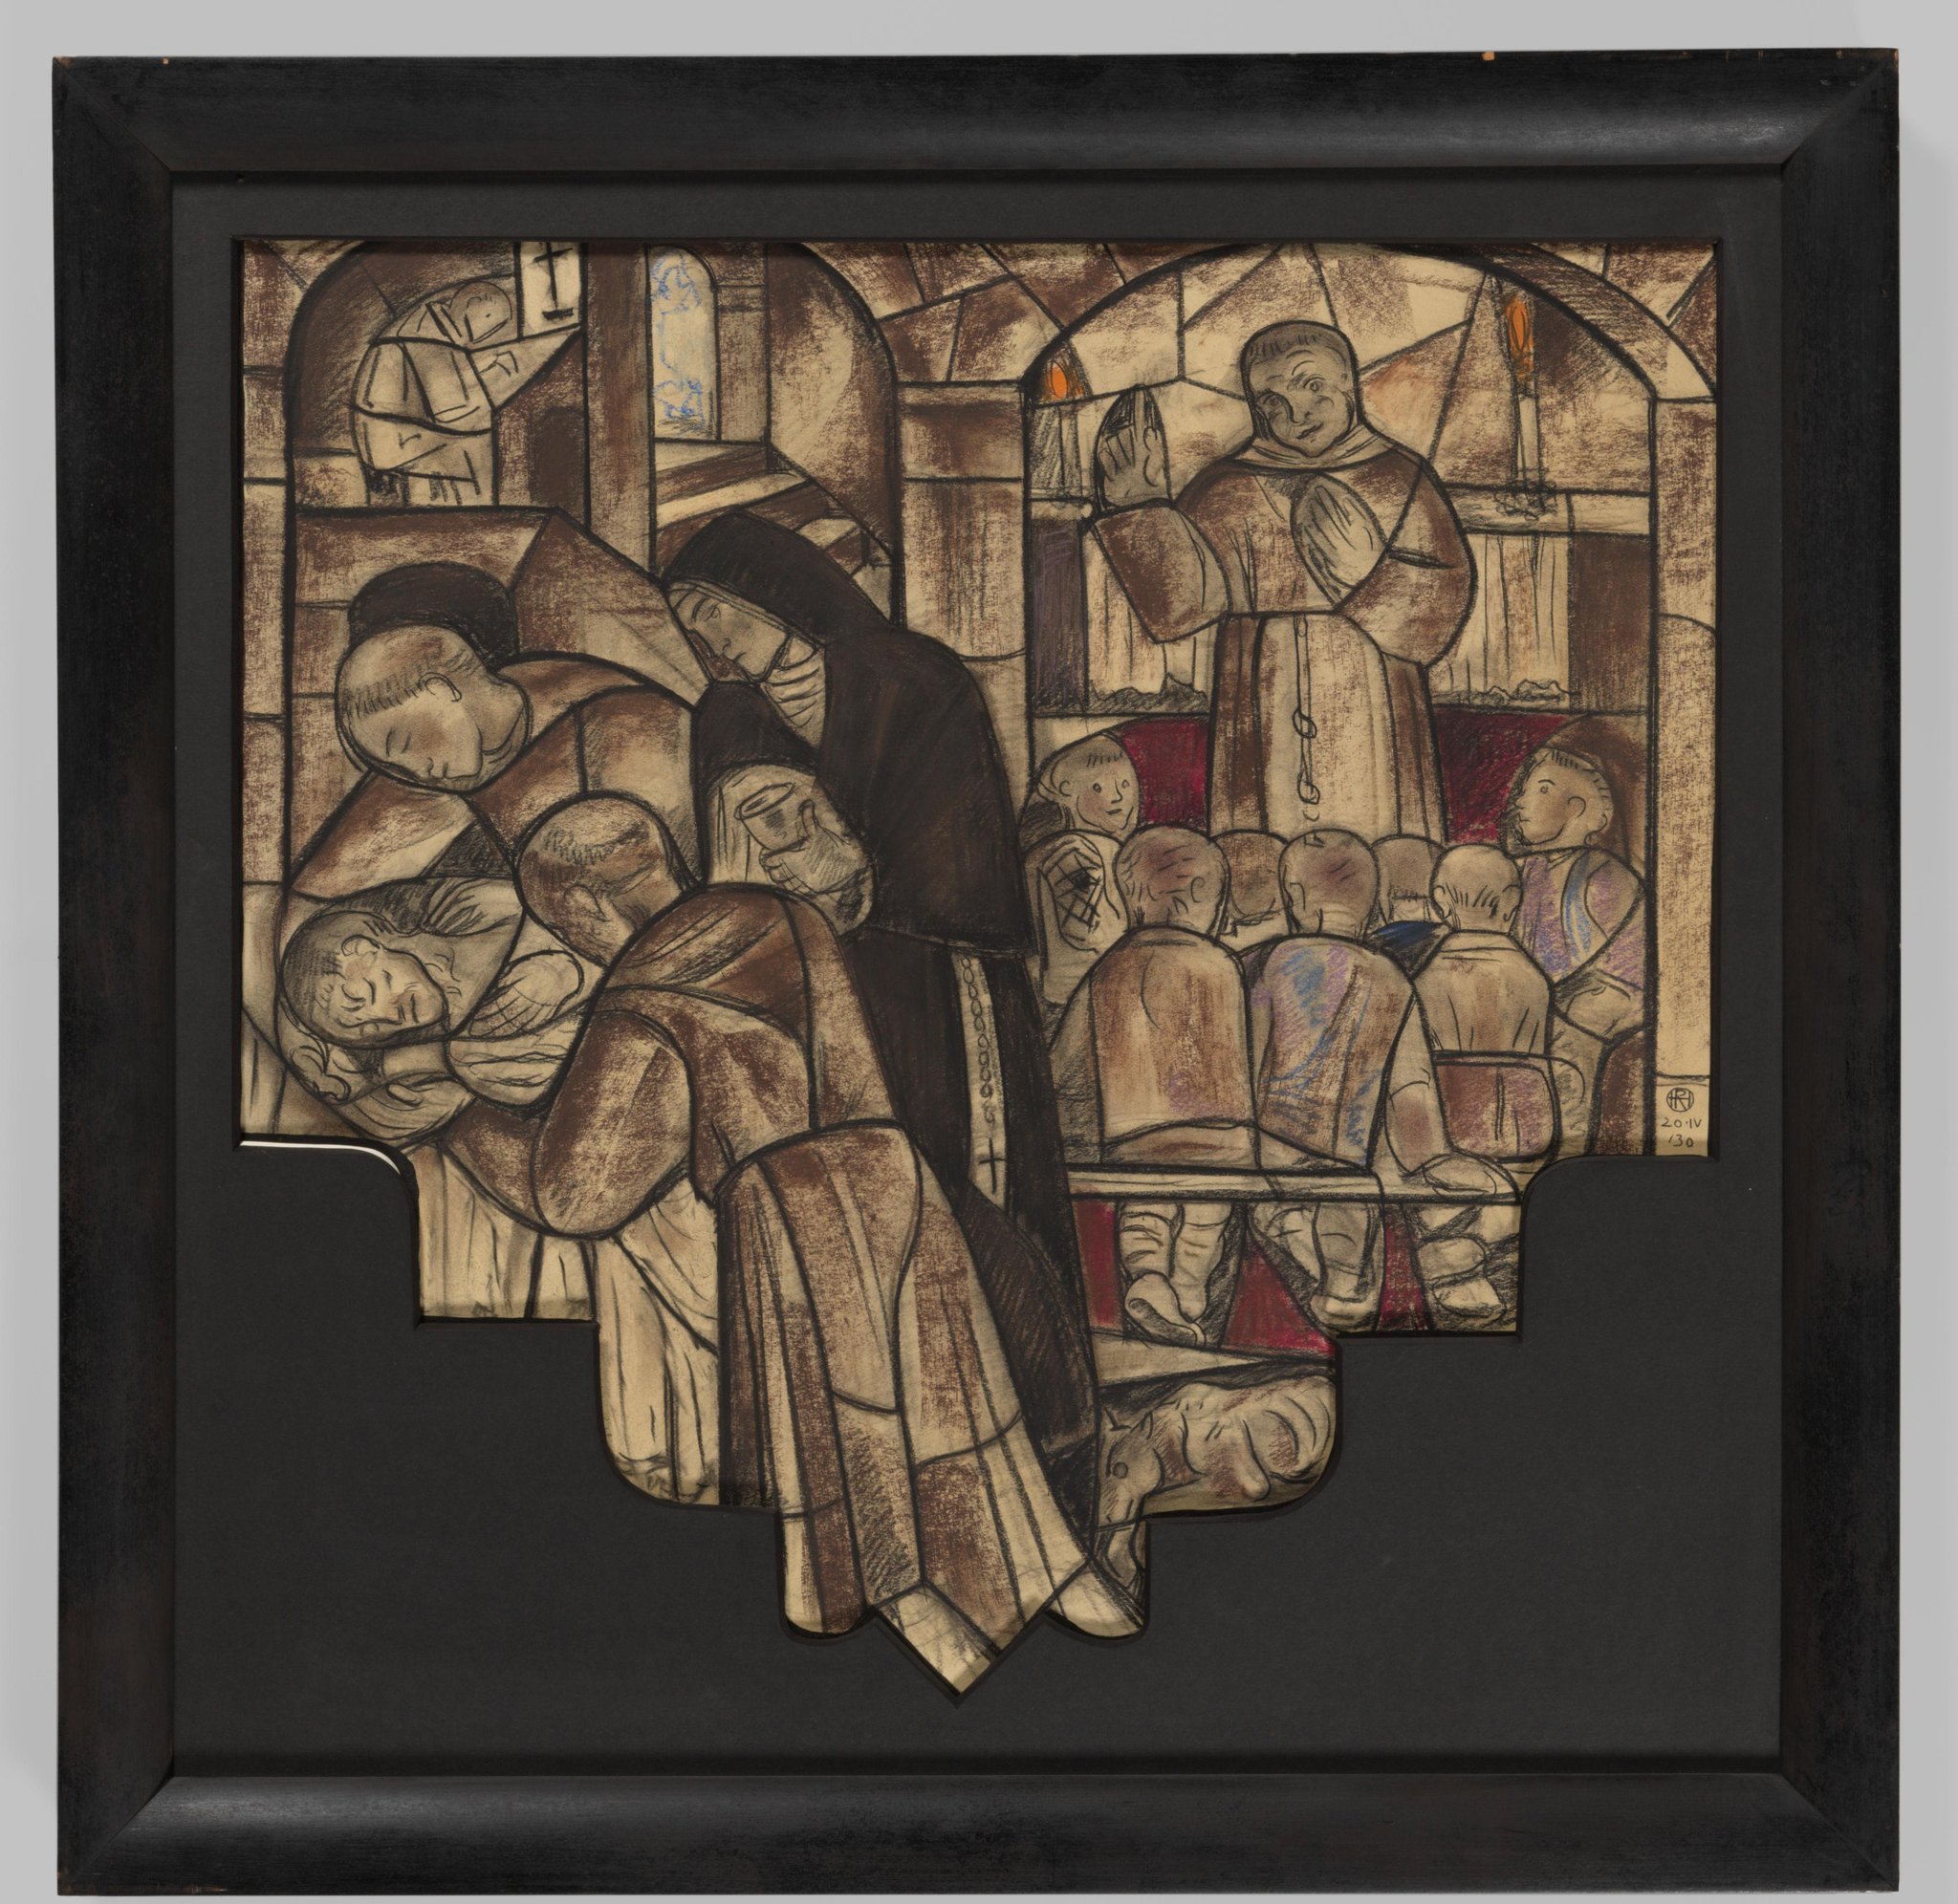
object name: design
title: Ontwerp voor raam in het Stadhuis in Amsterdam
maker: richard nicolaüs roland holst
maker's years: 1868-1938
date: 1930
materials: cardboard, chalk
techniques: brush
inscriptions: date: ‘20.IV.'30’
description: De vrouwelijke zorg, en de priesterlijke zorg.